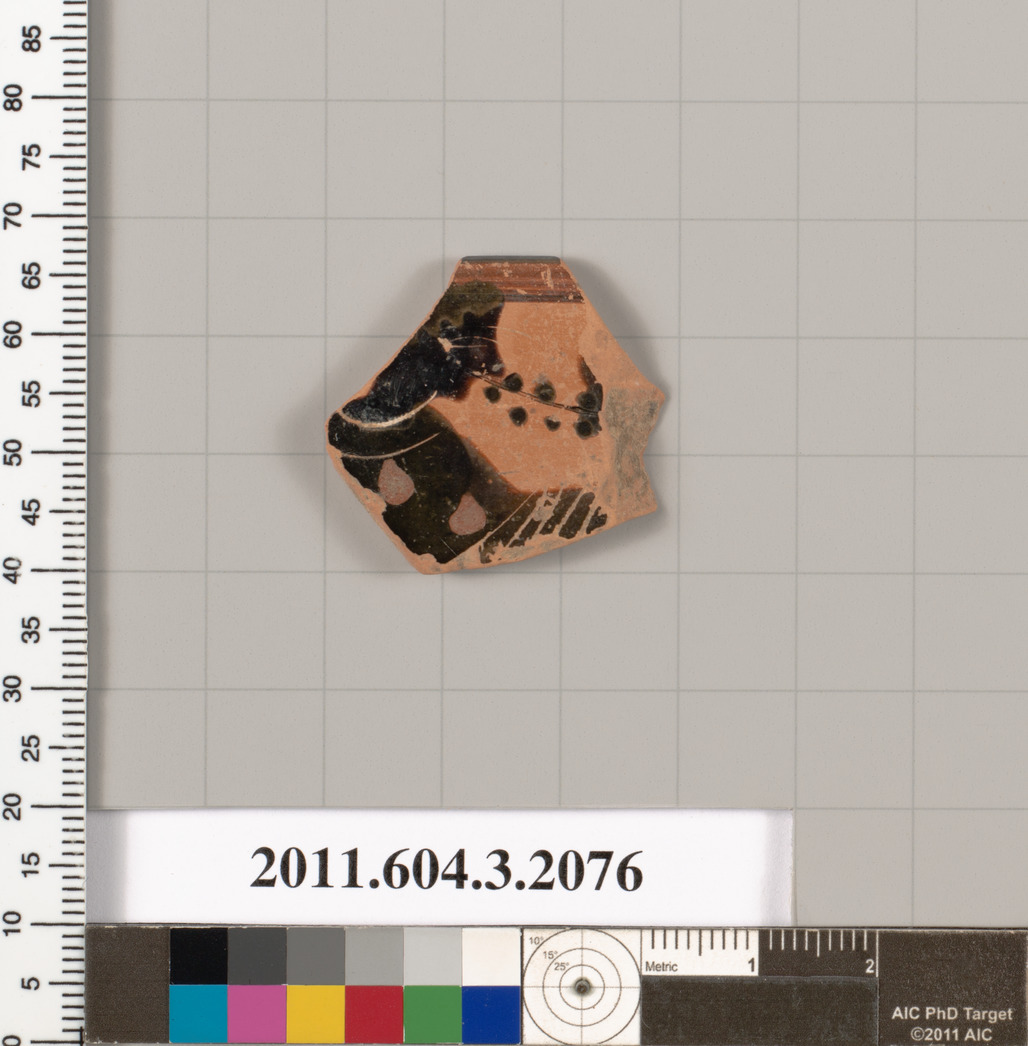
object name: kylix fragment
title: Terracotta rim fragment of a kylix (drinking cup)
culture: greek, attic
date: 500-468 BCE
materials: terracotta